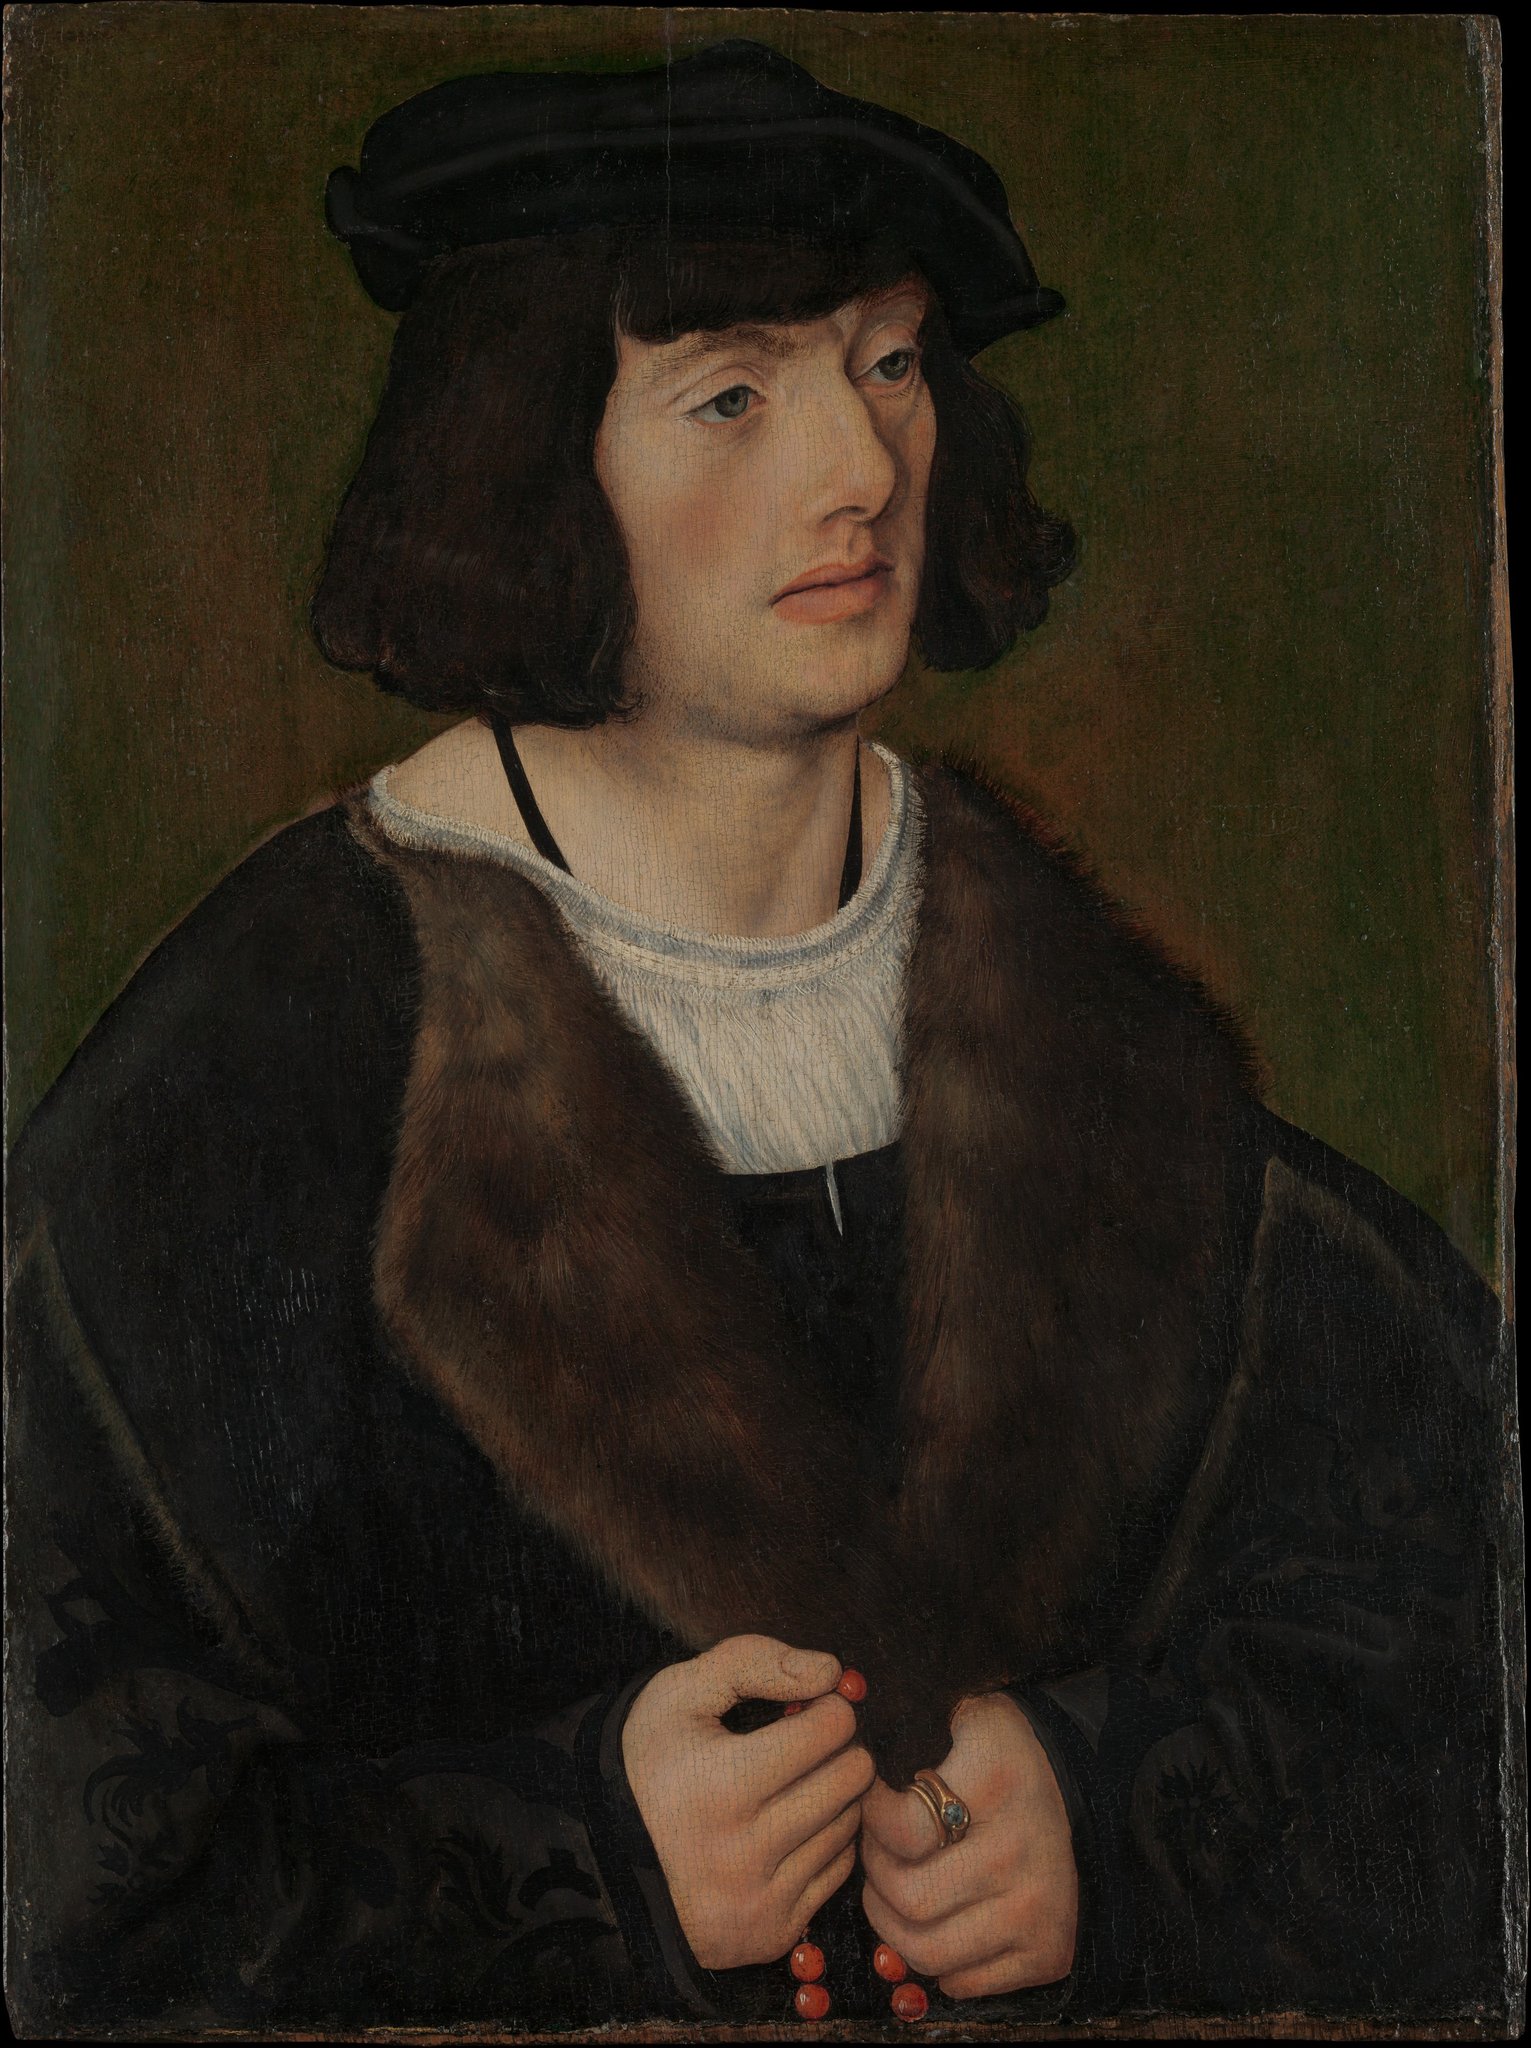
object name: painting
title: Portrait of a Man with a Rosary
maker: lucas cranach the elder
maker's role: artist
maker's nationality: german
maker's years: 1472-1553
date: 1508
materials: wood, oil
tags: men,portraits,rosaries